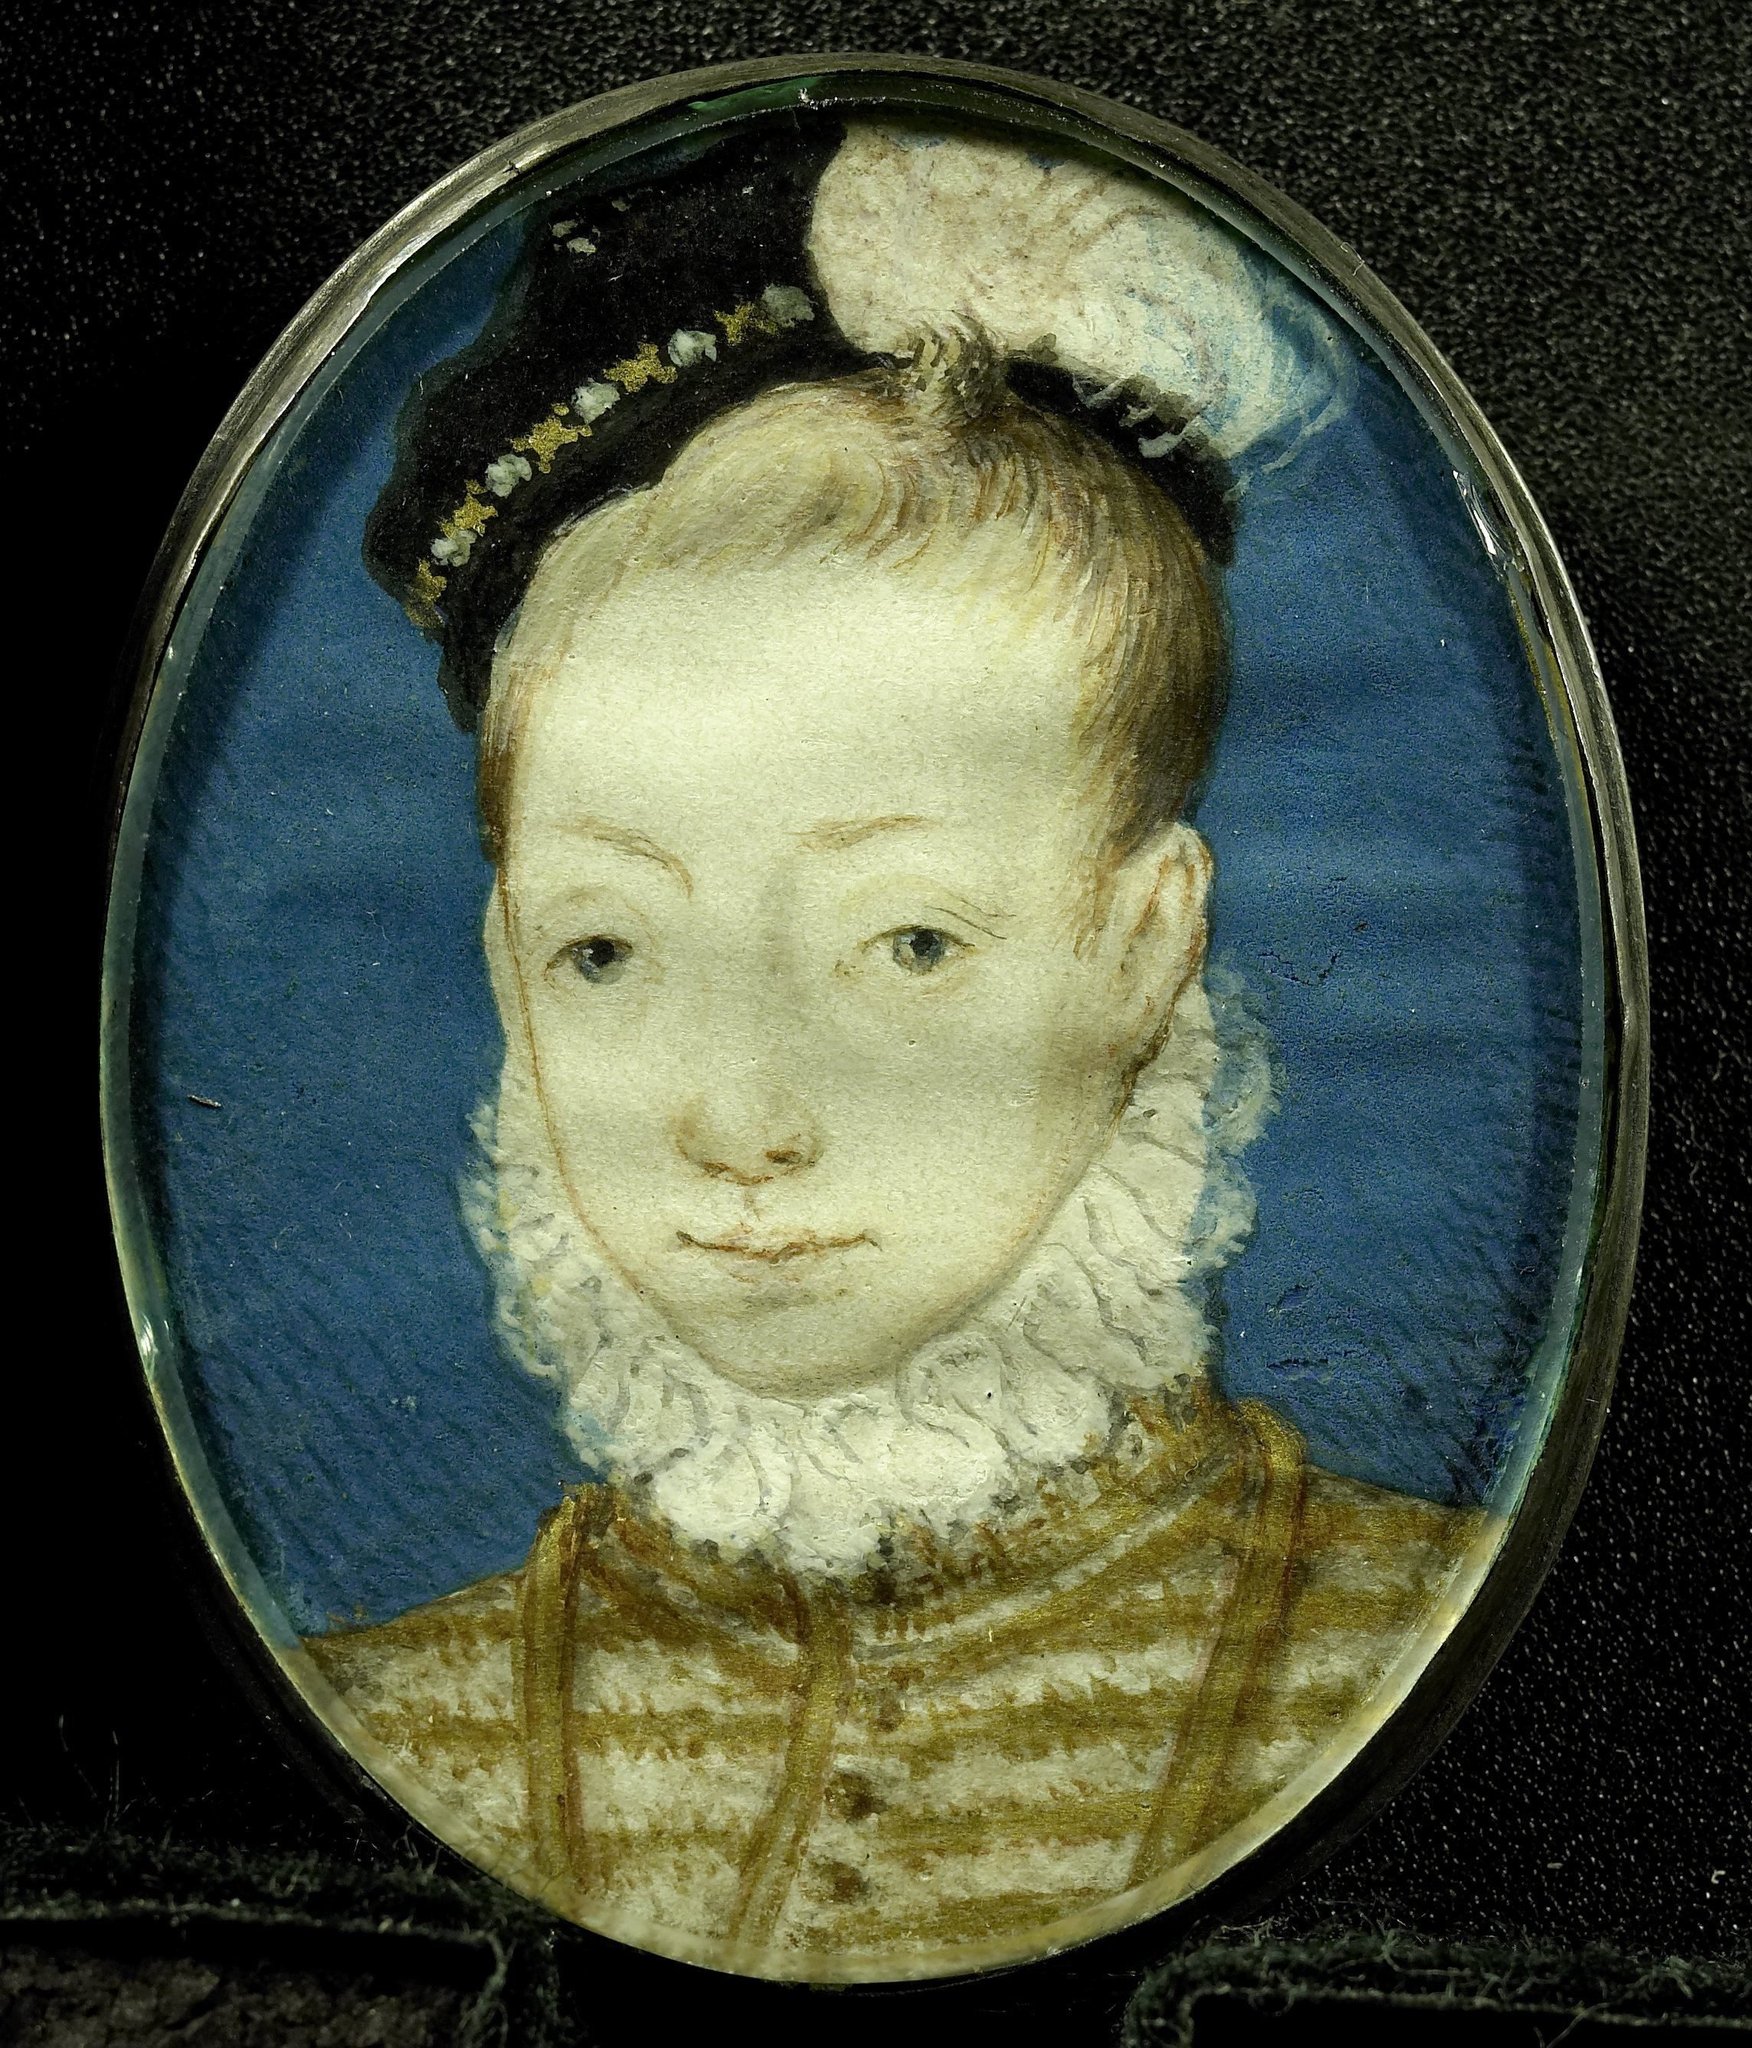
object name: painting, miniature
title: Jacobus Stuart (1566-1625), de latere koning Jacobus I van Engeland, op ongeveer tienjarige leeftijd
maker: Anonymous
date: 1600-1699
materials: glass, parchment, silver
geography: england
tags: jacobus i (koning van engeland)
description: Portret van Jacobus Stuart (1566-1625), de latere koning Jacobus I van Engeland, op ongeveer tienjarige leeftijd. Buste, aanziend, met gepluimde baret. Latere kopie voor een reeks vorstenportretten. Onderdeel van de collectie portretminiaturen.